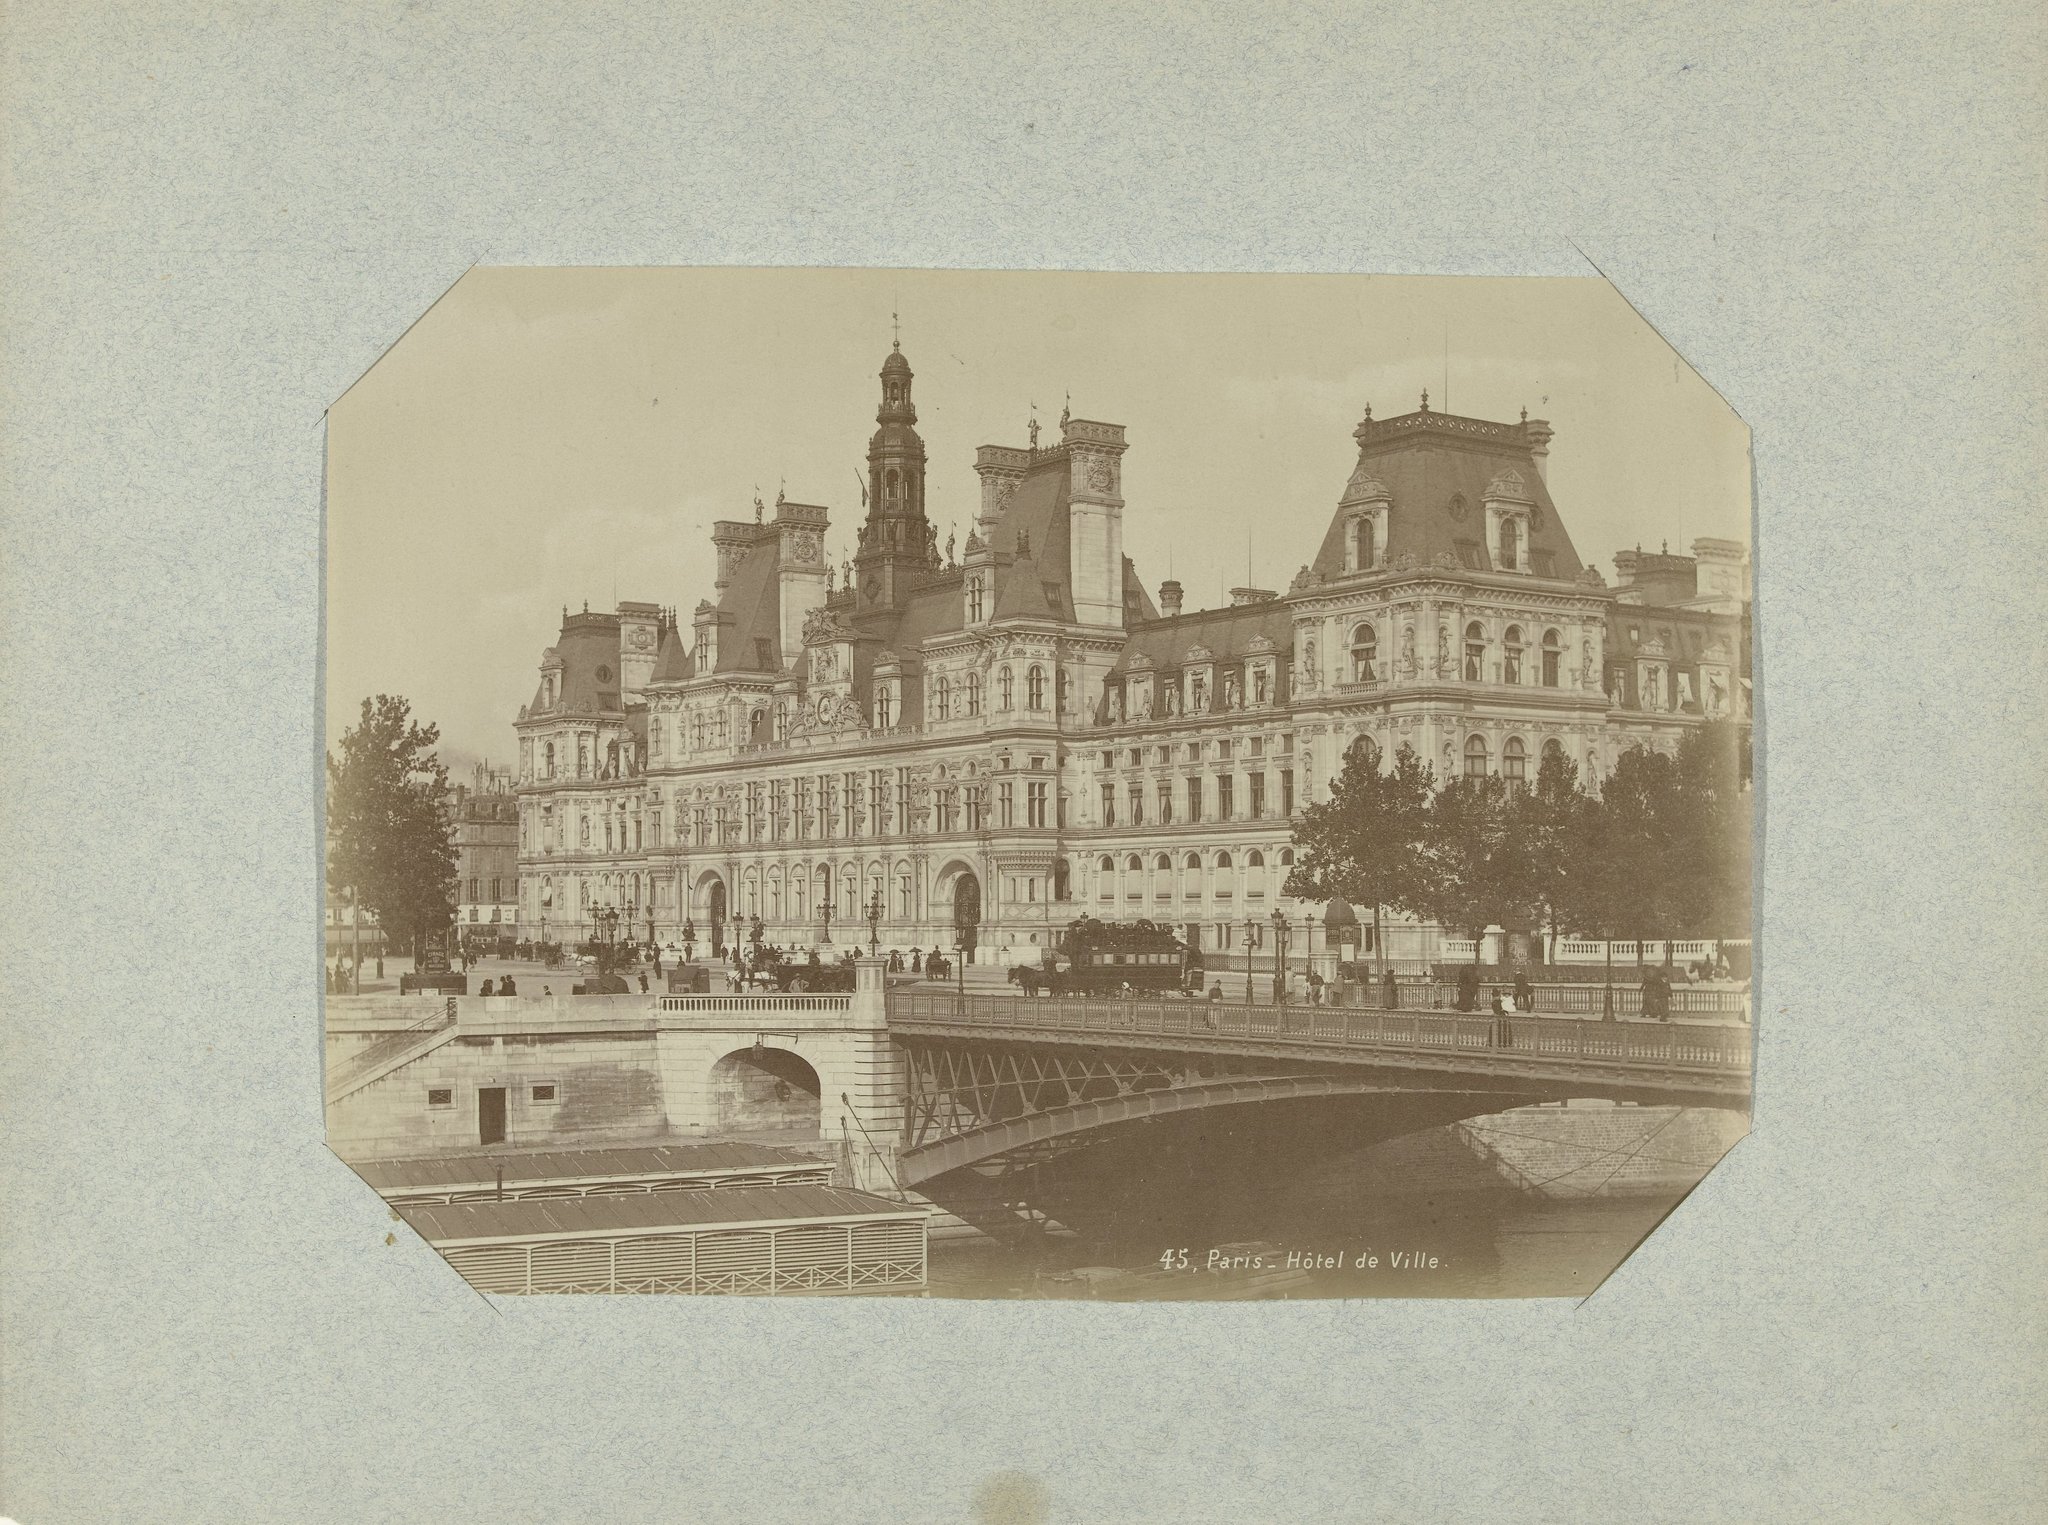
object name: photograph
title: Paris - Hôtel de Ville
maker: Anonymous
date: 1851-1900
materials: cardboard, paper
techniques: albumen print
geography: paris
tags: townhall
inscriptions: number: ‘45.’